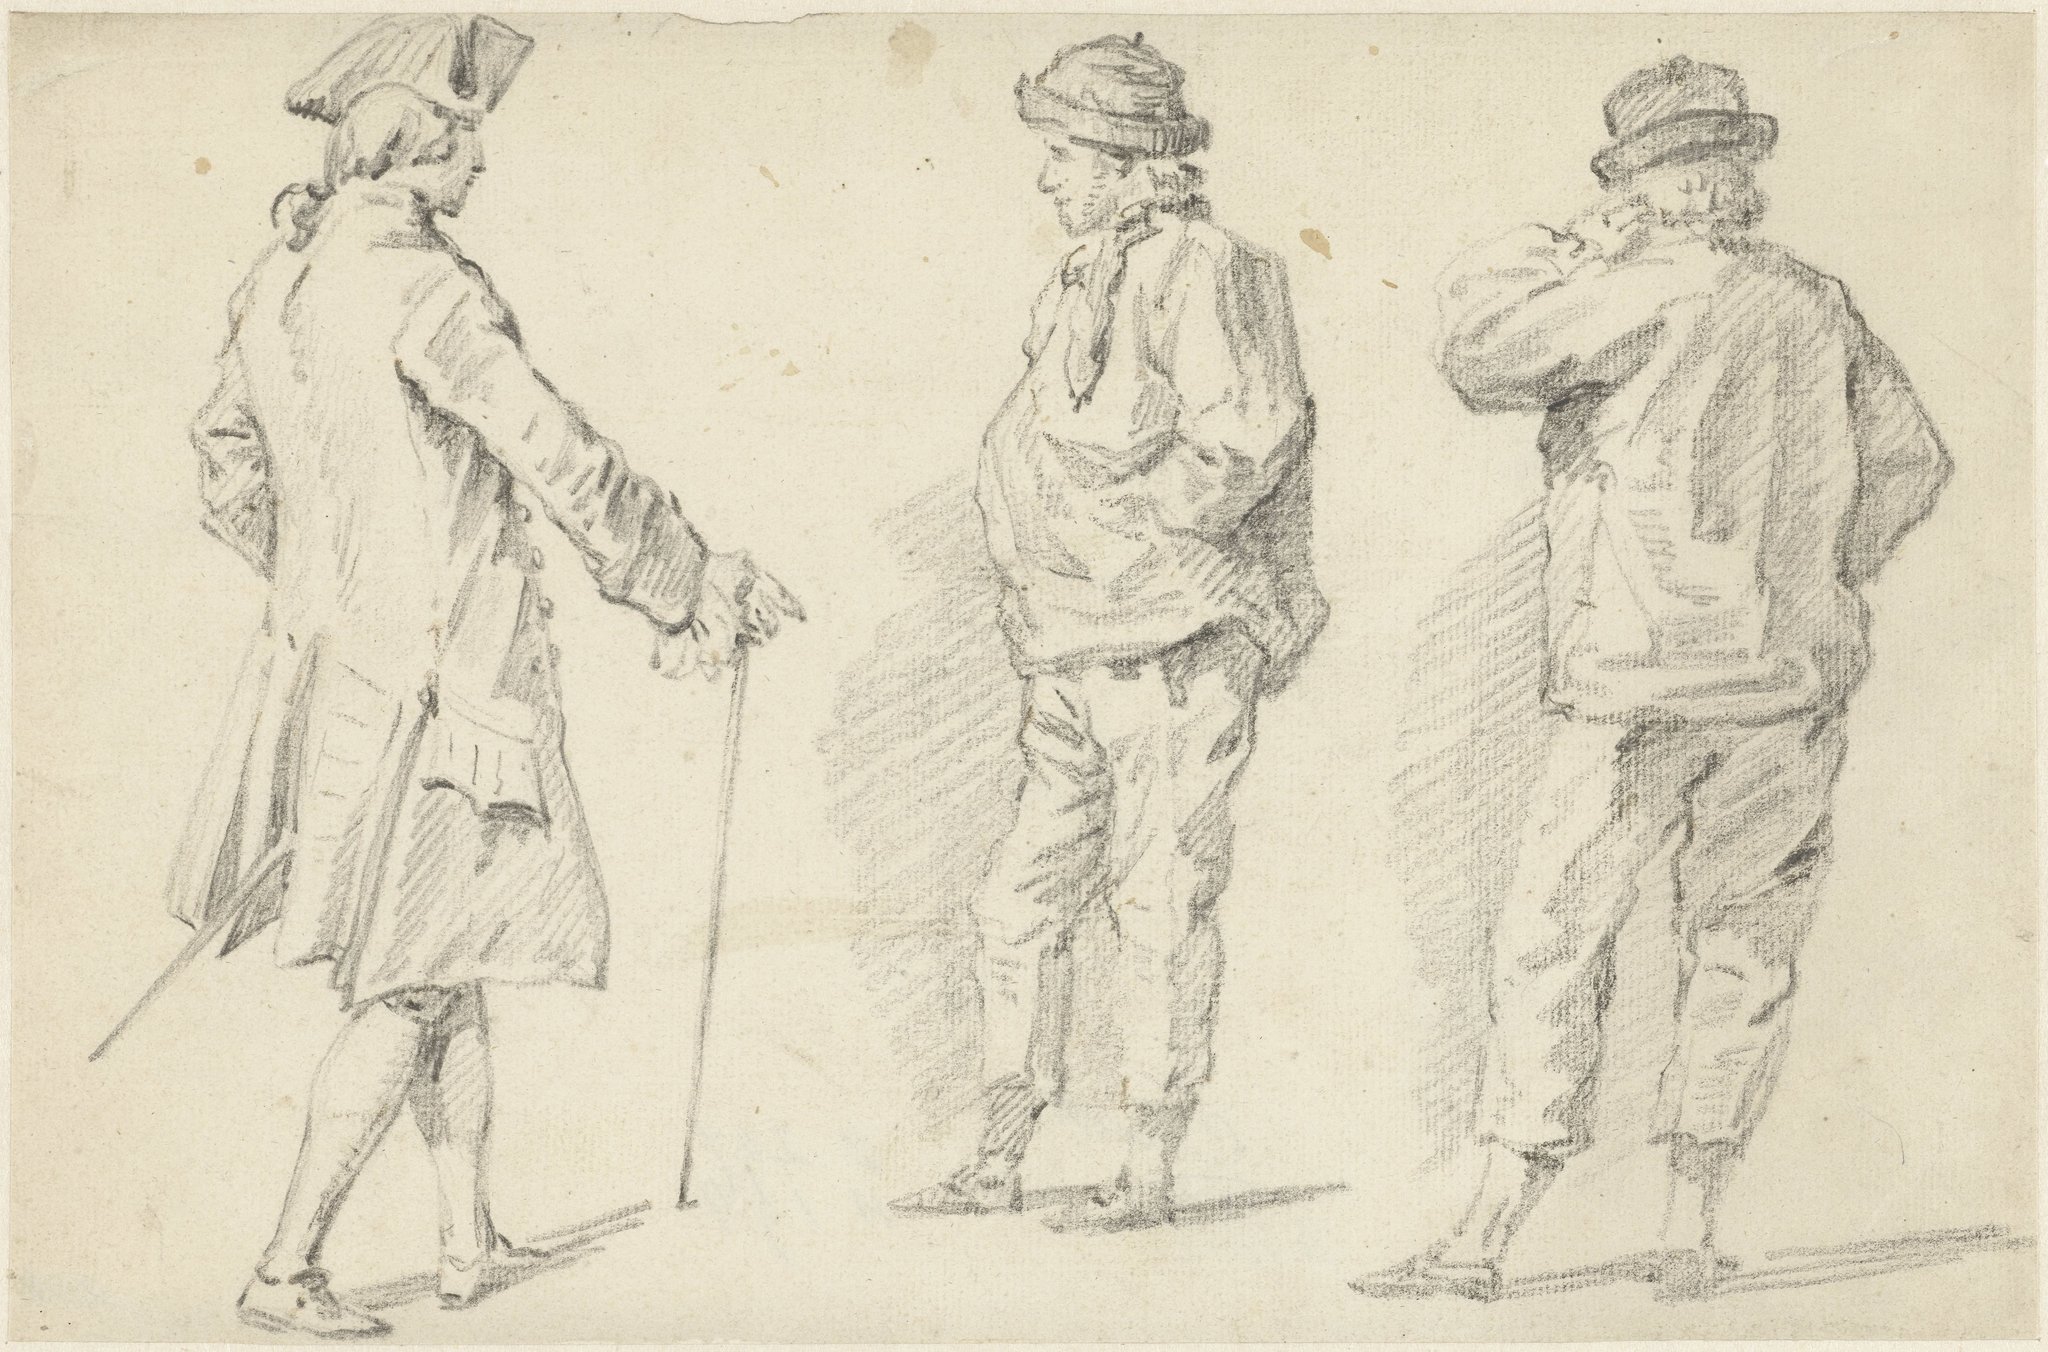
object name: drawing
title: Studieblad met drie staande figuren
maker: simon fokke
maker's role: draughtsman, print maker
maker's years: 1712-1784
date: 1722-1784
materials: chalk, paper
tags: standing figure